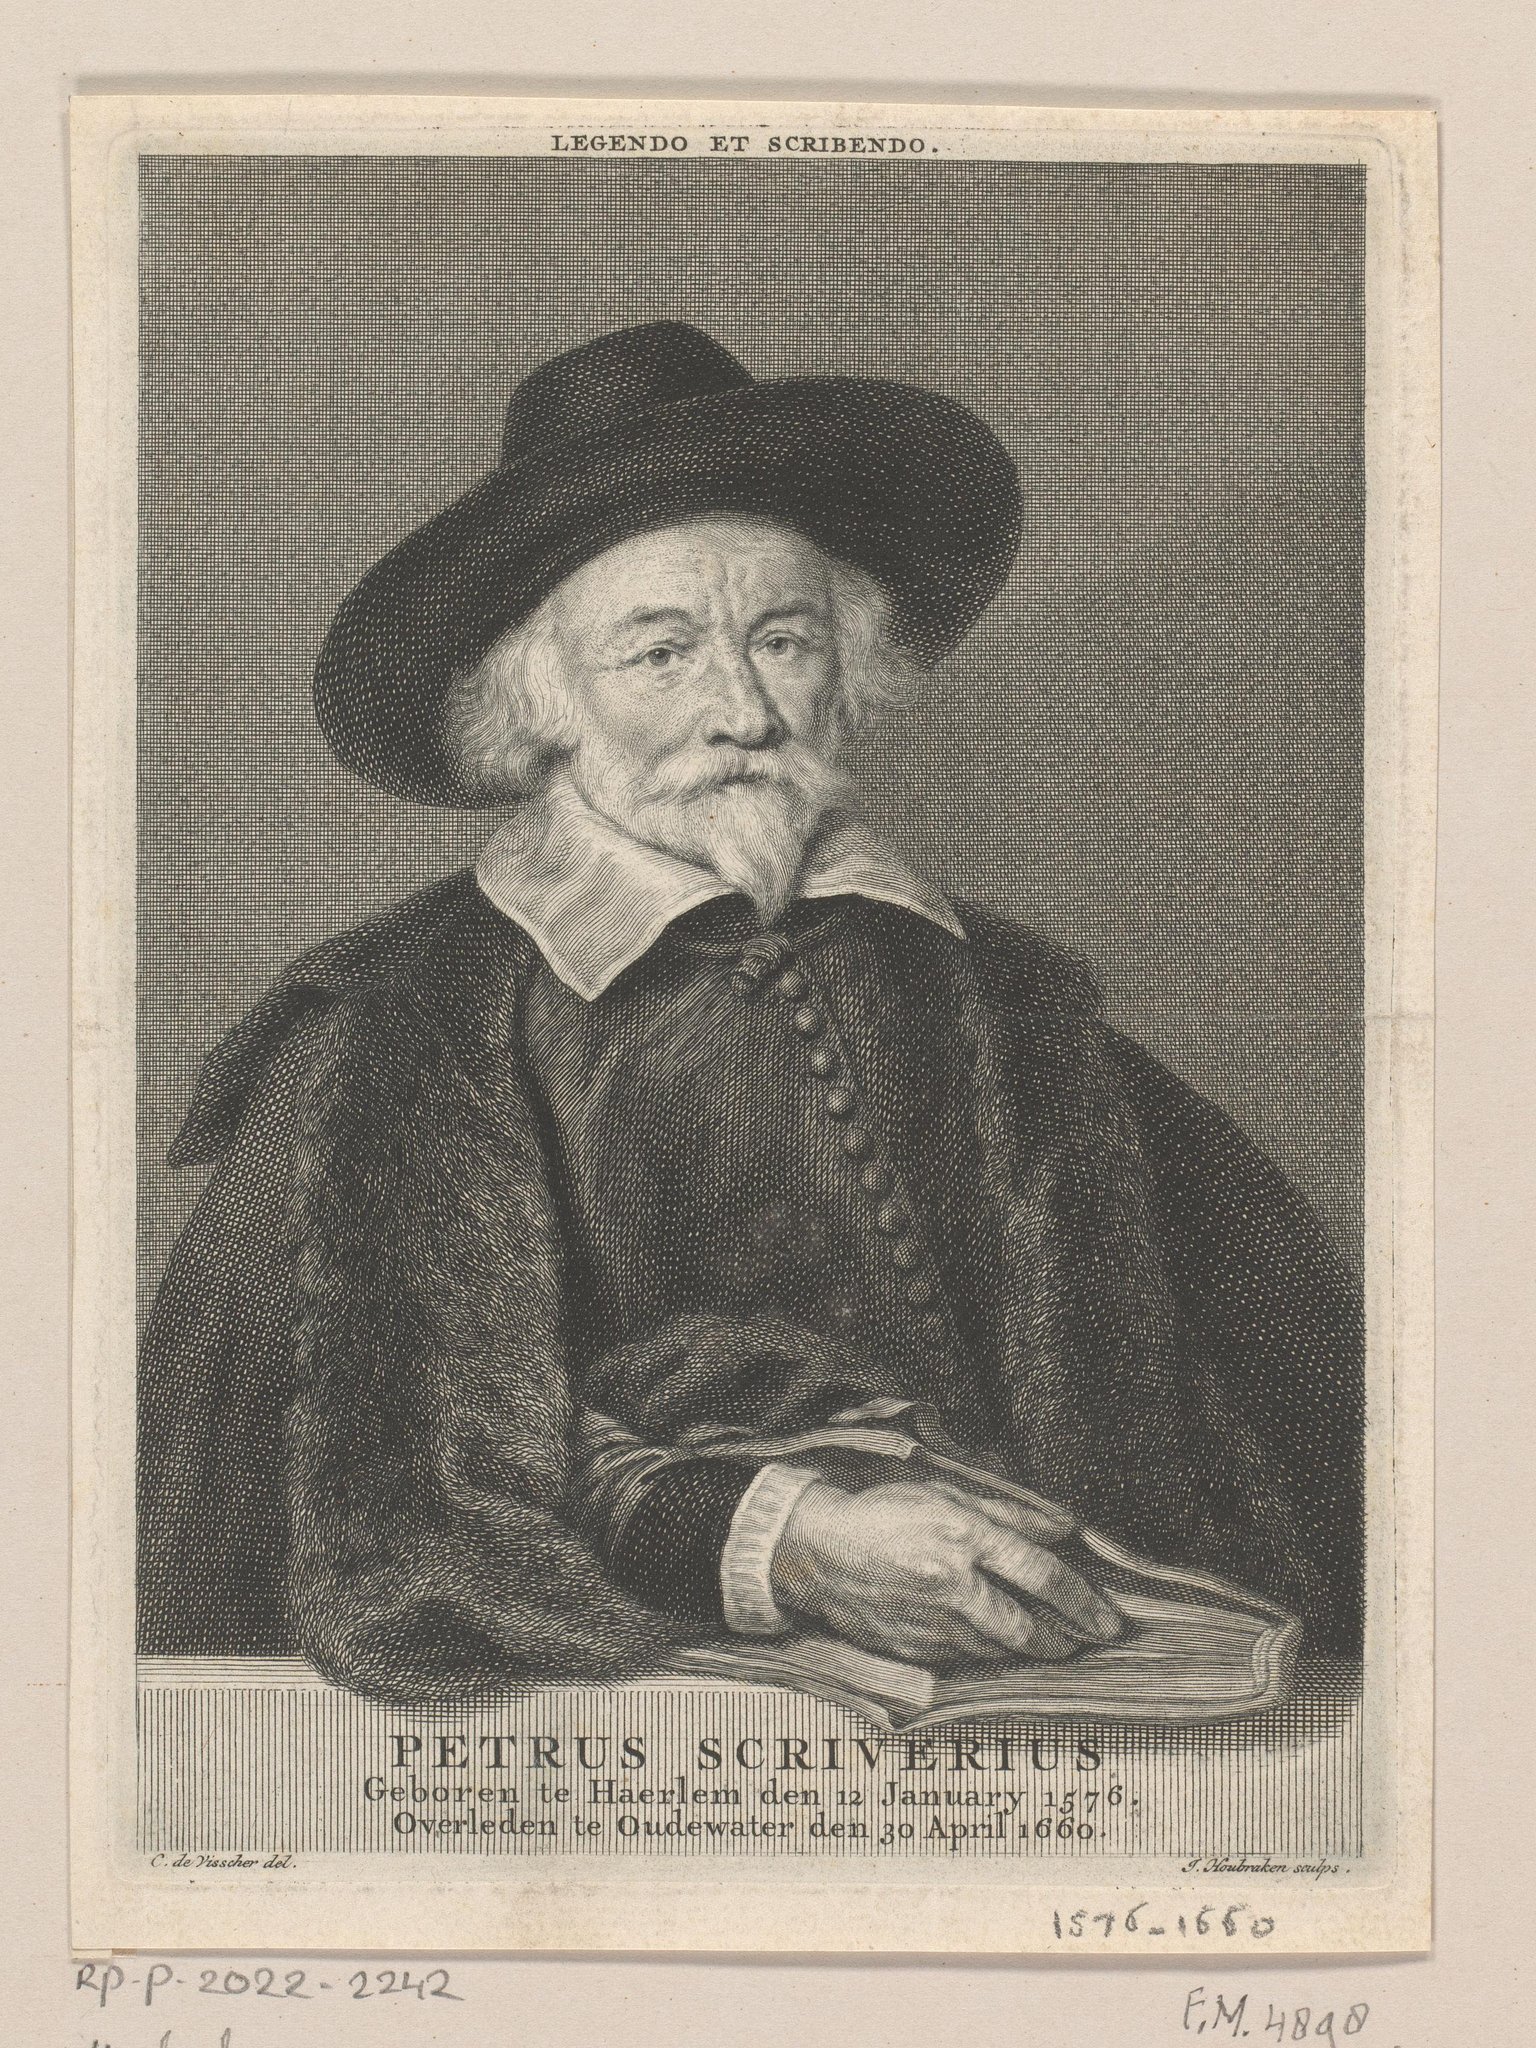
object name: print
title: Portret van Petrus Scriverius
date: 1708-1780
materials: paper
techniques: engraving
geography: amsterdam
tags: petrus scriverius, historical persons, portrait of a writer, scholar, philosopher (+ portrait of scholar, scientist)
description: Met tweeregelig onderschrift in het Nederlands.